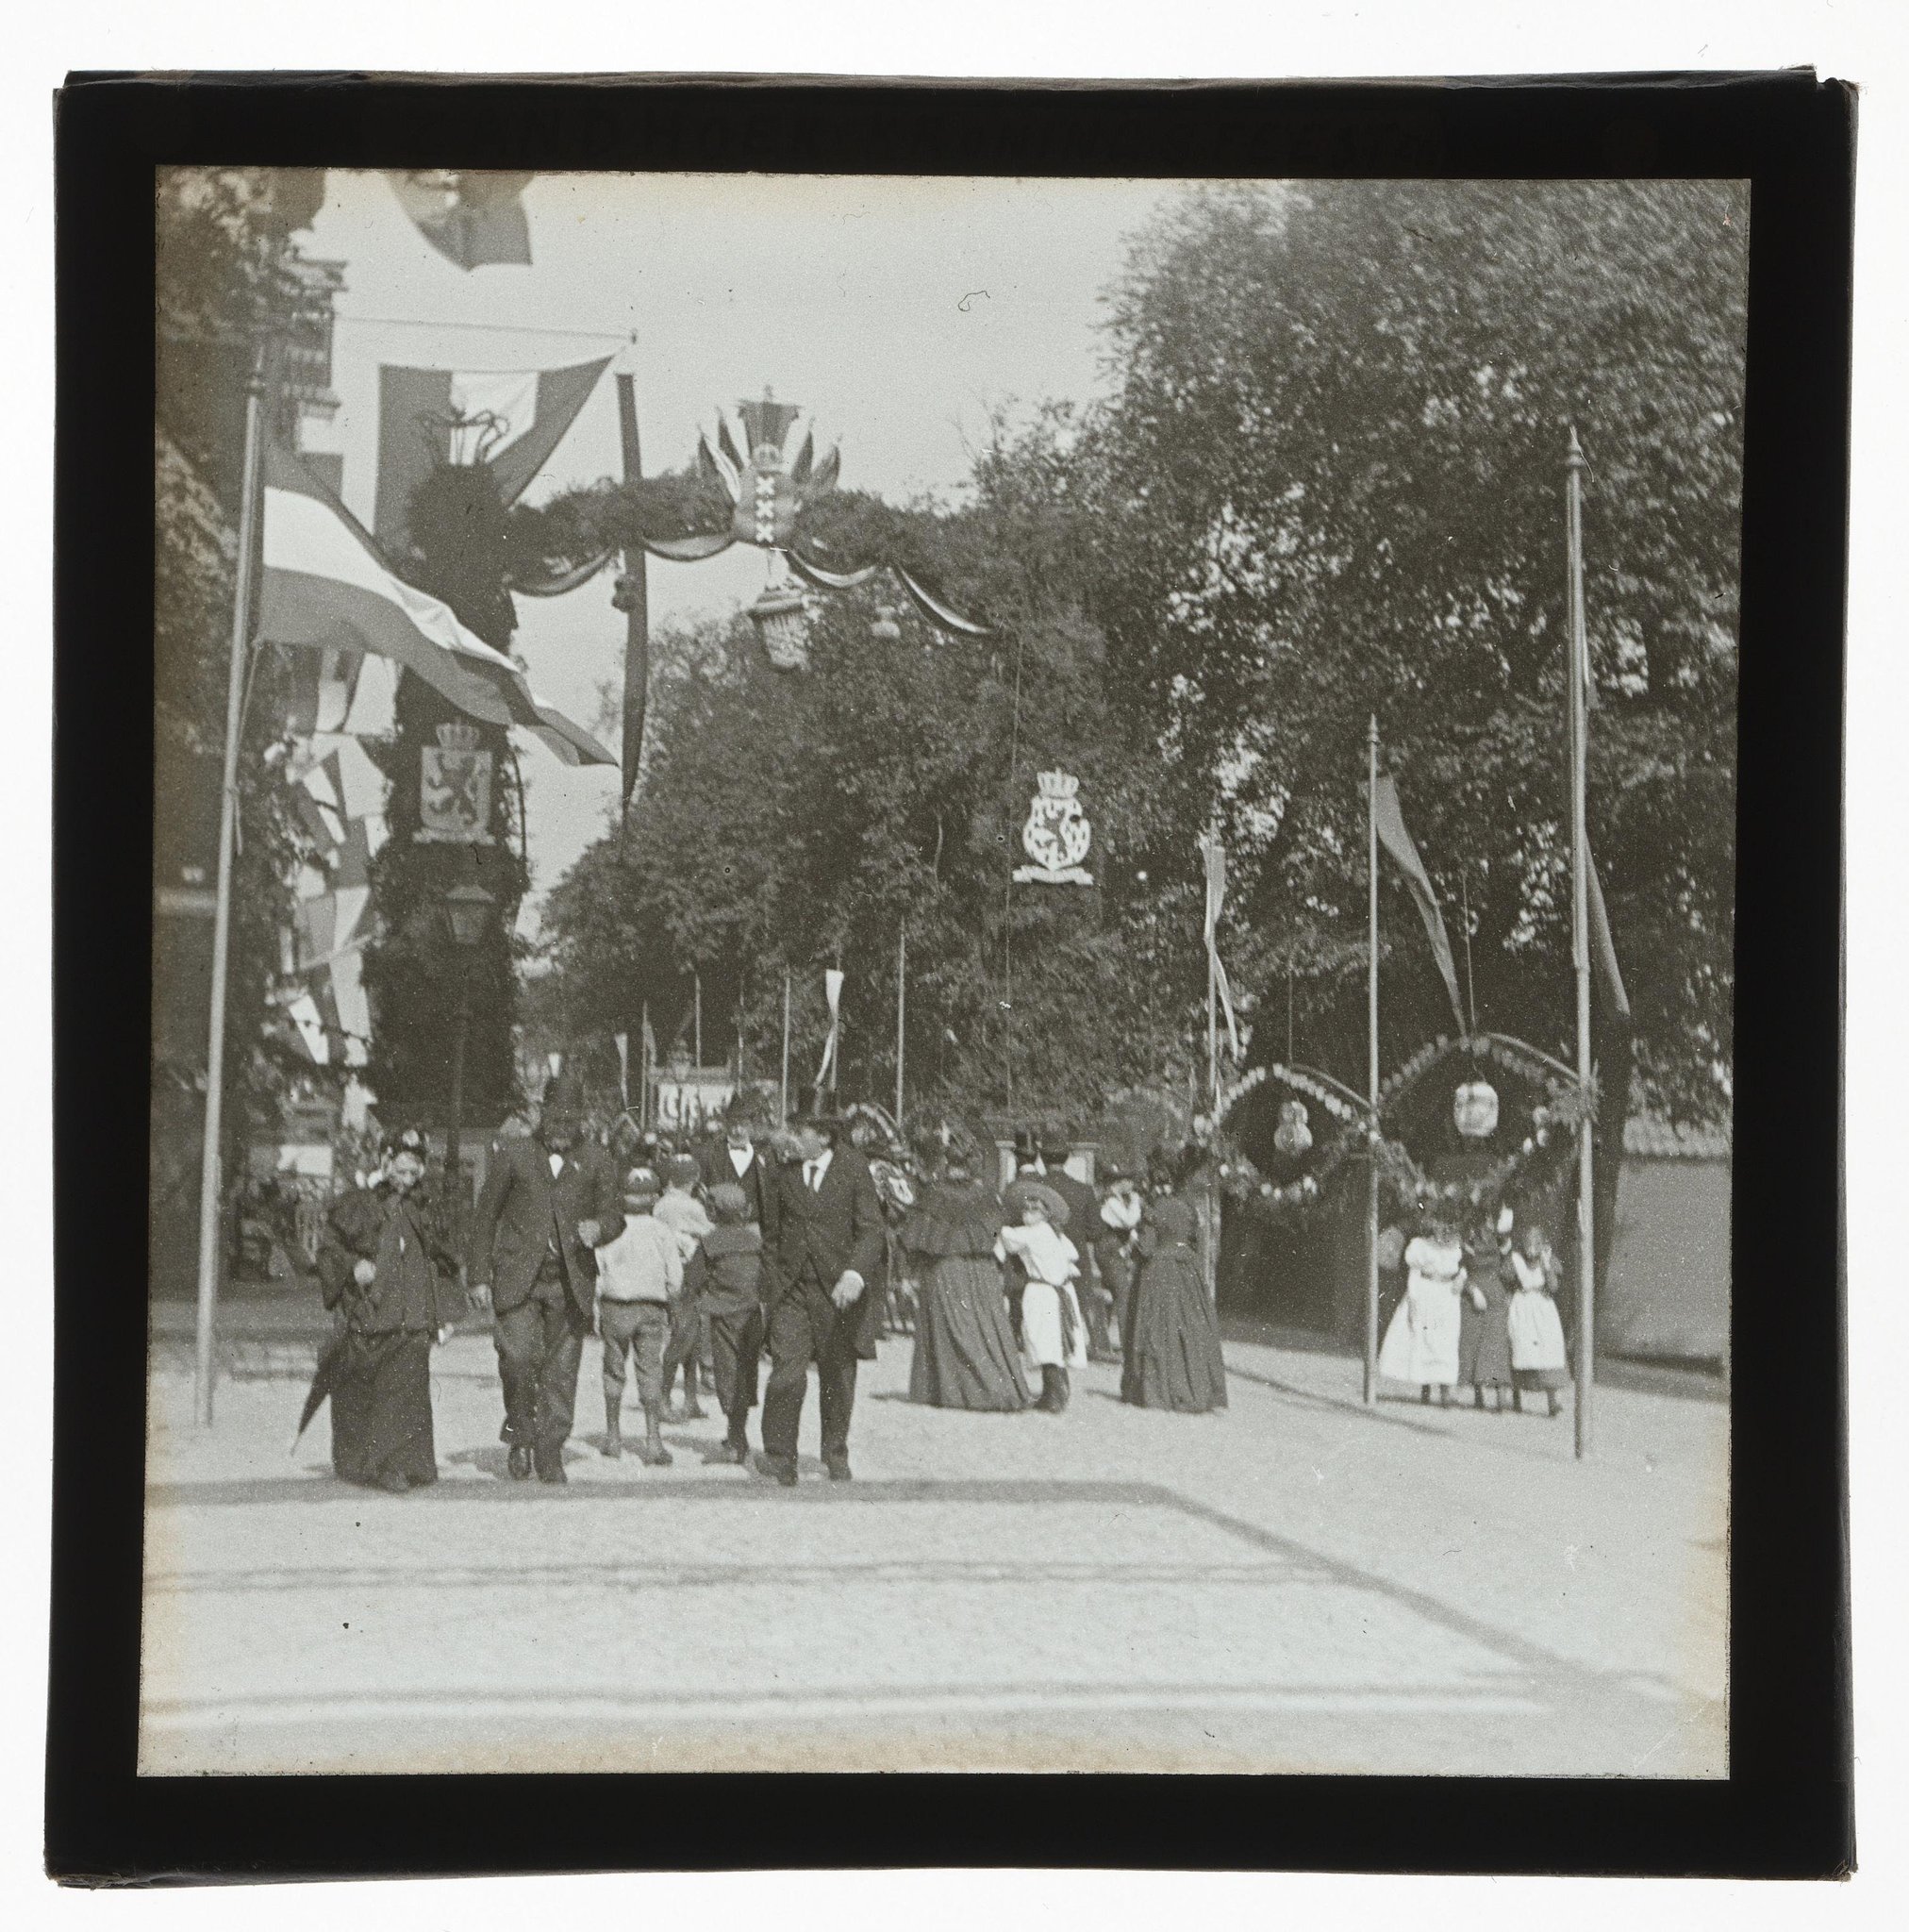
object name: lantern slide photographic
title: Mensen bij de Zandhoek tijdens de Kroningsfeesten in 1898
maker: machiel gerrit george suyver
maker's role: fotograaf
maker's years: 1872-1933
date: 1898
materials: glass, paper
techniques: gelatin silver transparency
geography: zandhoek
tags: public festivities on the occasion of royal events